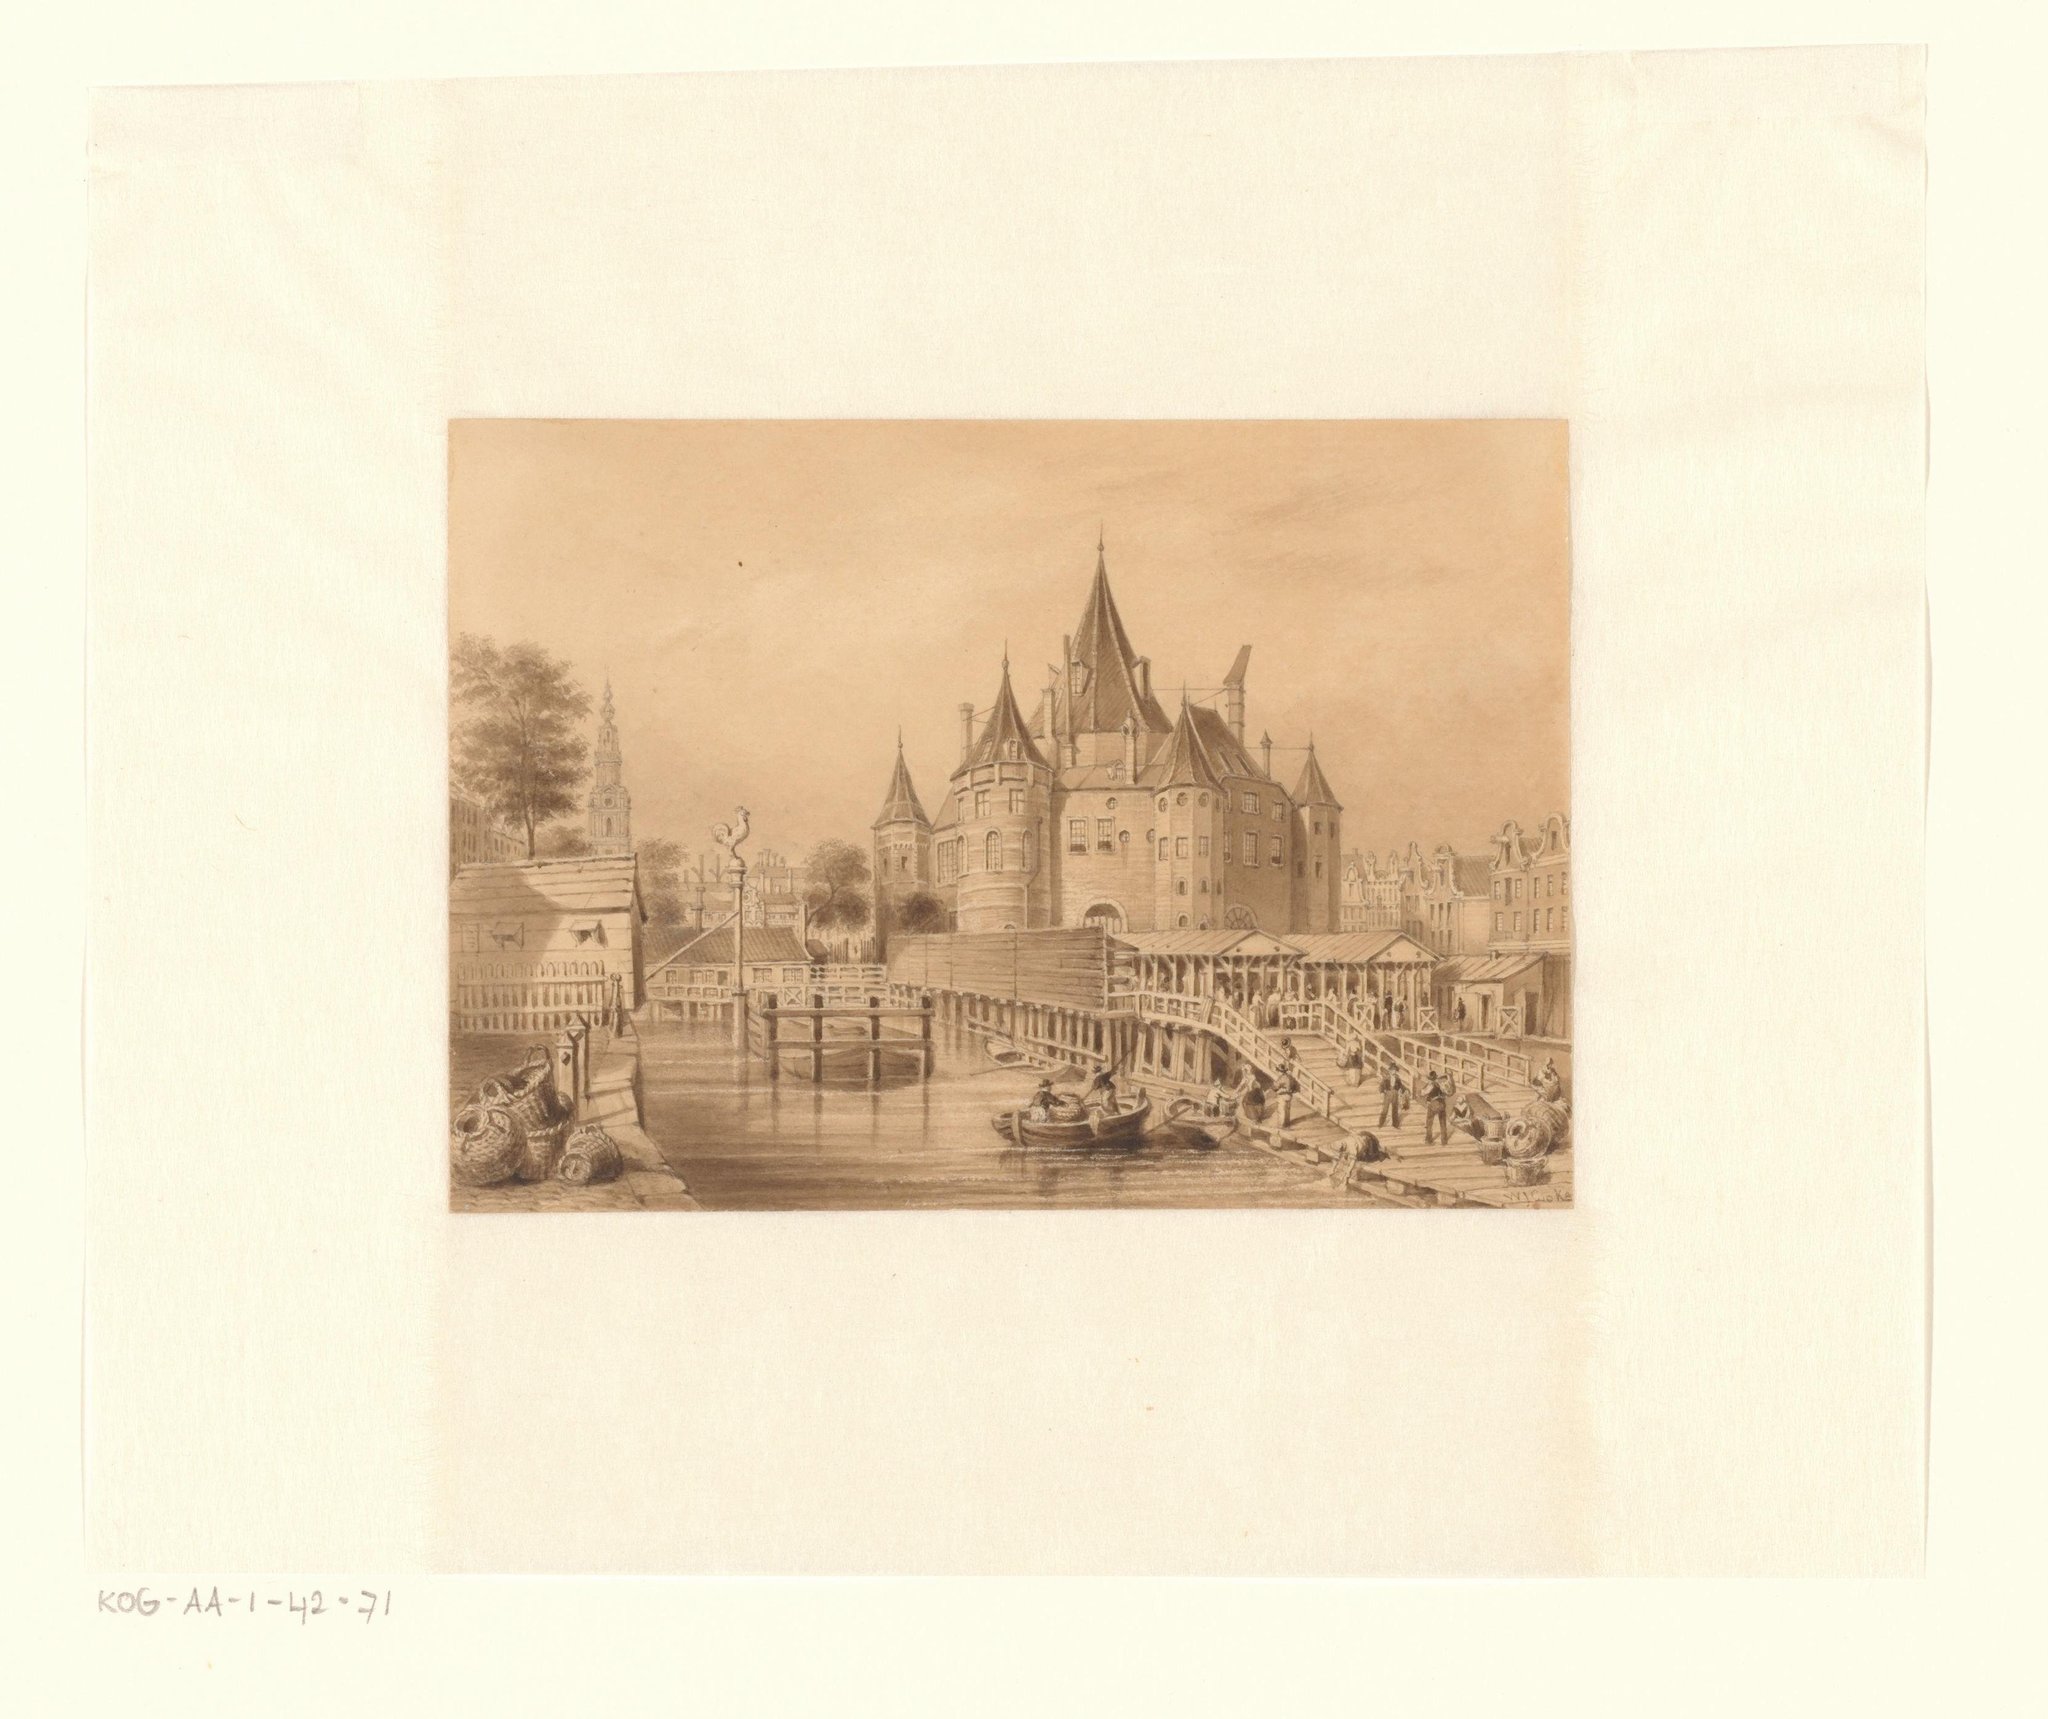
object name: drawing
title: Gezicht op de Waag vanaf de Geldersekade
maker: william john cooke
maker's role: print maker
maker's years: 1797-1865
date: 1807-1865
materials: ink, paper, pencil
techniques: brush, pen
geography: amsterdam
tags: city-view in general; 'veduta', canal, bridge in city across river, canal, etc., weigh-house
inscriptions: signature: ‘WJCooke’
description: Onderwerpsrubriek binnen de Atlas Amsterdam: Veemen, Waaggebouwen.